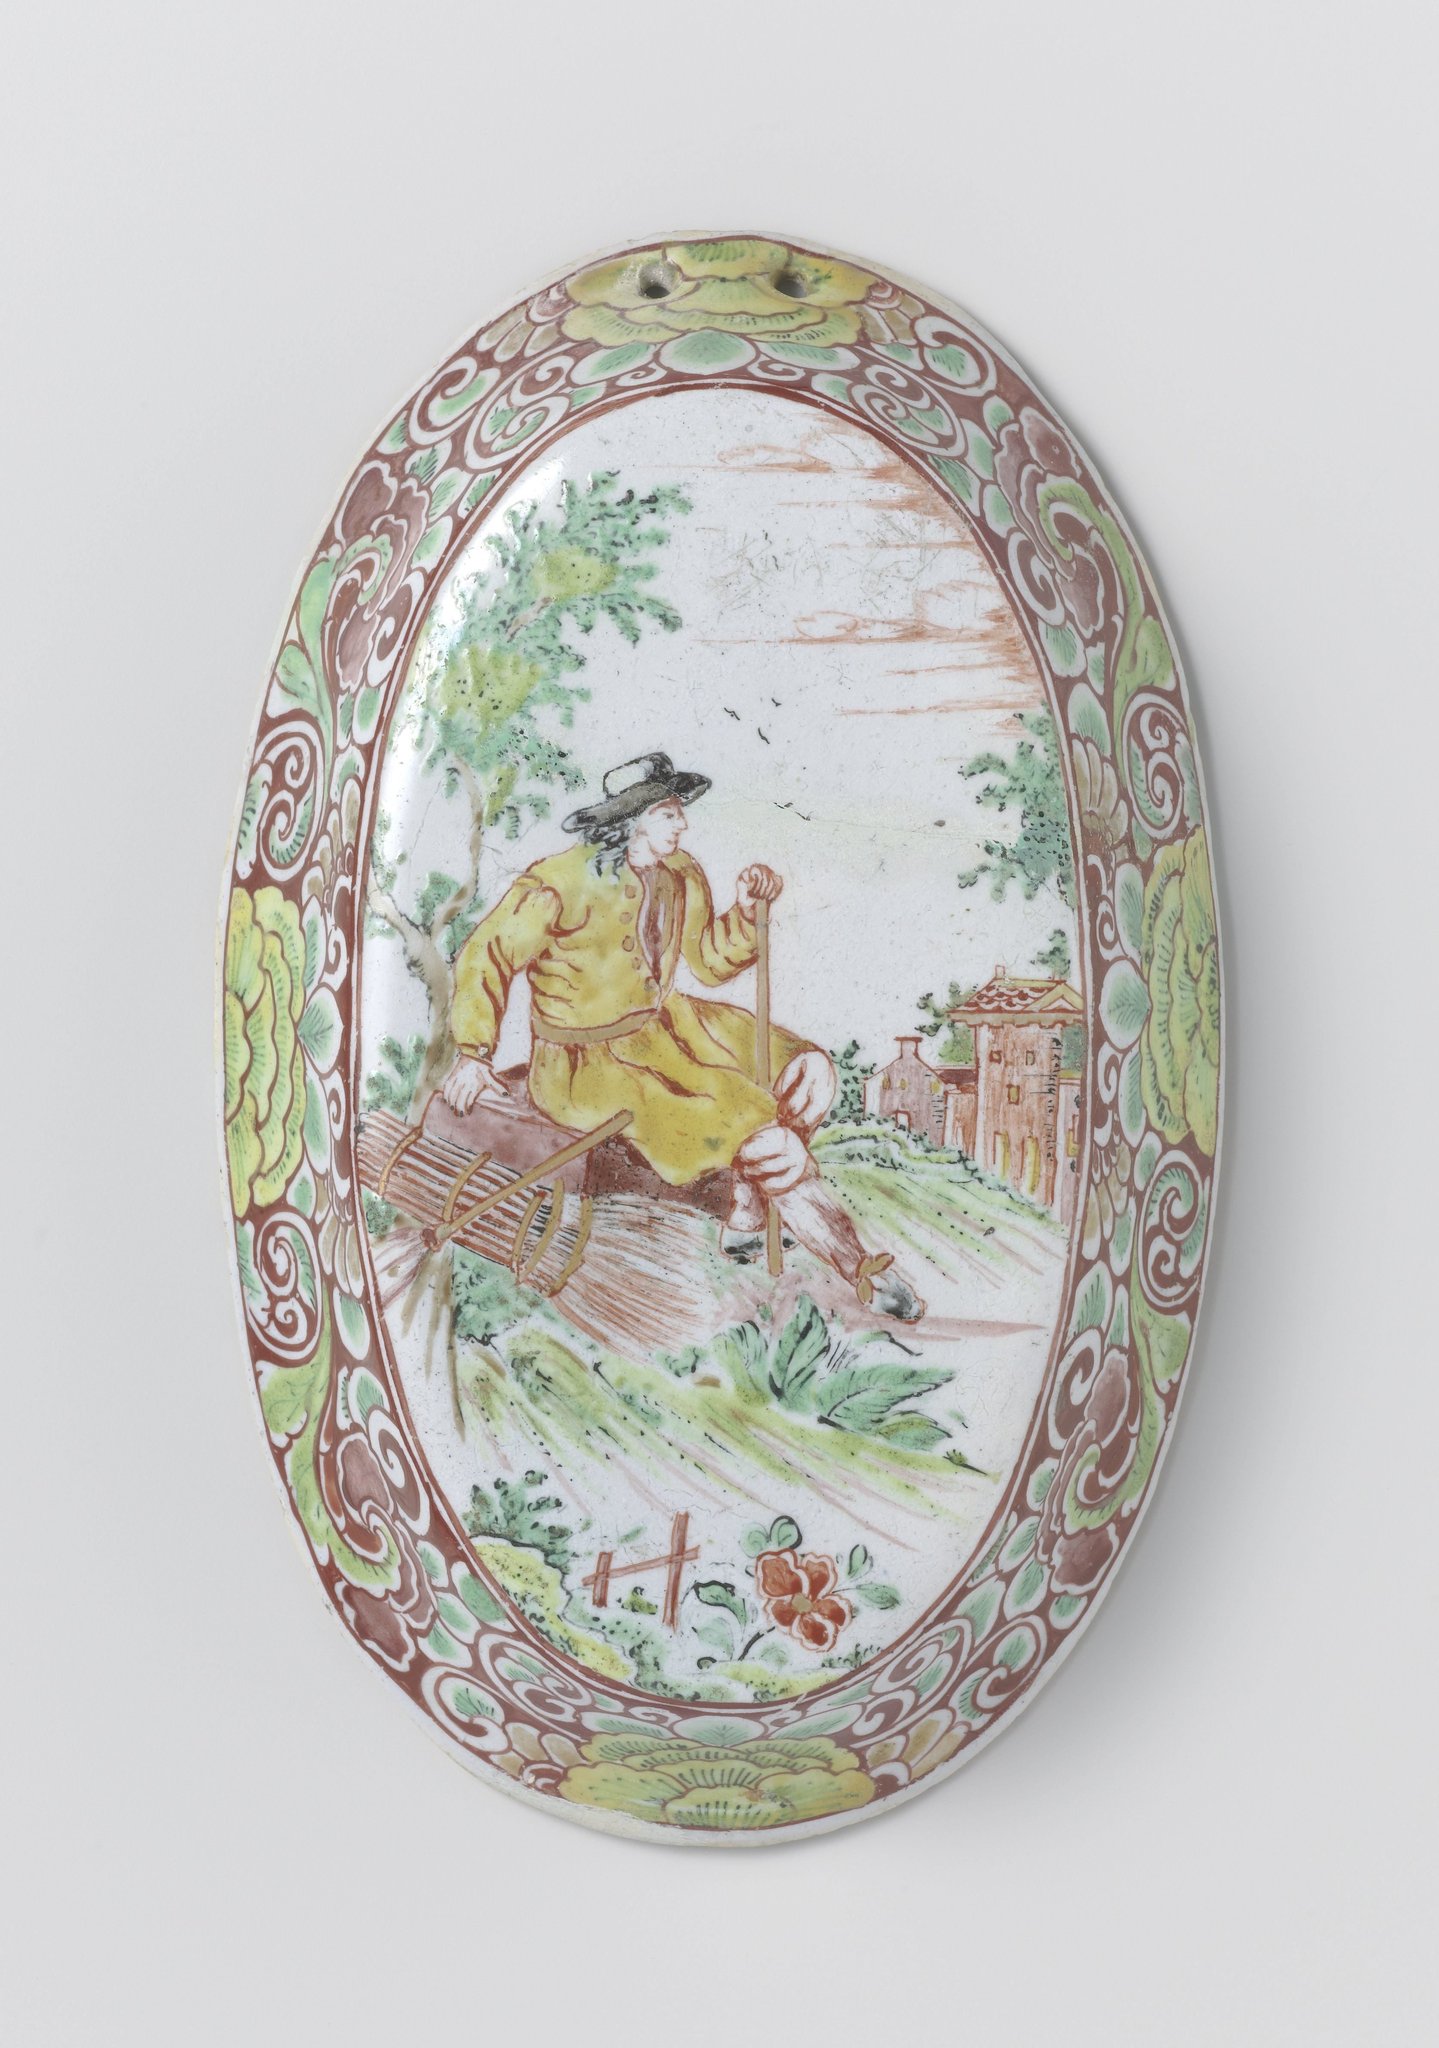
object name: borstelrug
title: Borstelrug, beschilderd met een pastorale scene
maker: Anonymous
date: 1725-1735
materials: faience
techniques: kiln, painted, polychromy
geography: delft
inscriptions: collector's mark: ‘collection J.F. Loudon’, inscription: ‘35 (in rood)/ 9 (in zwart)’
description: Borstelrug van faïence, veelkleurig beschilderd met een herder zittend in een landschap.